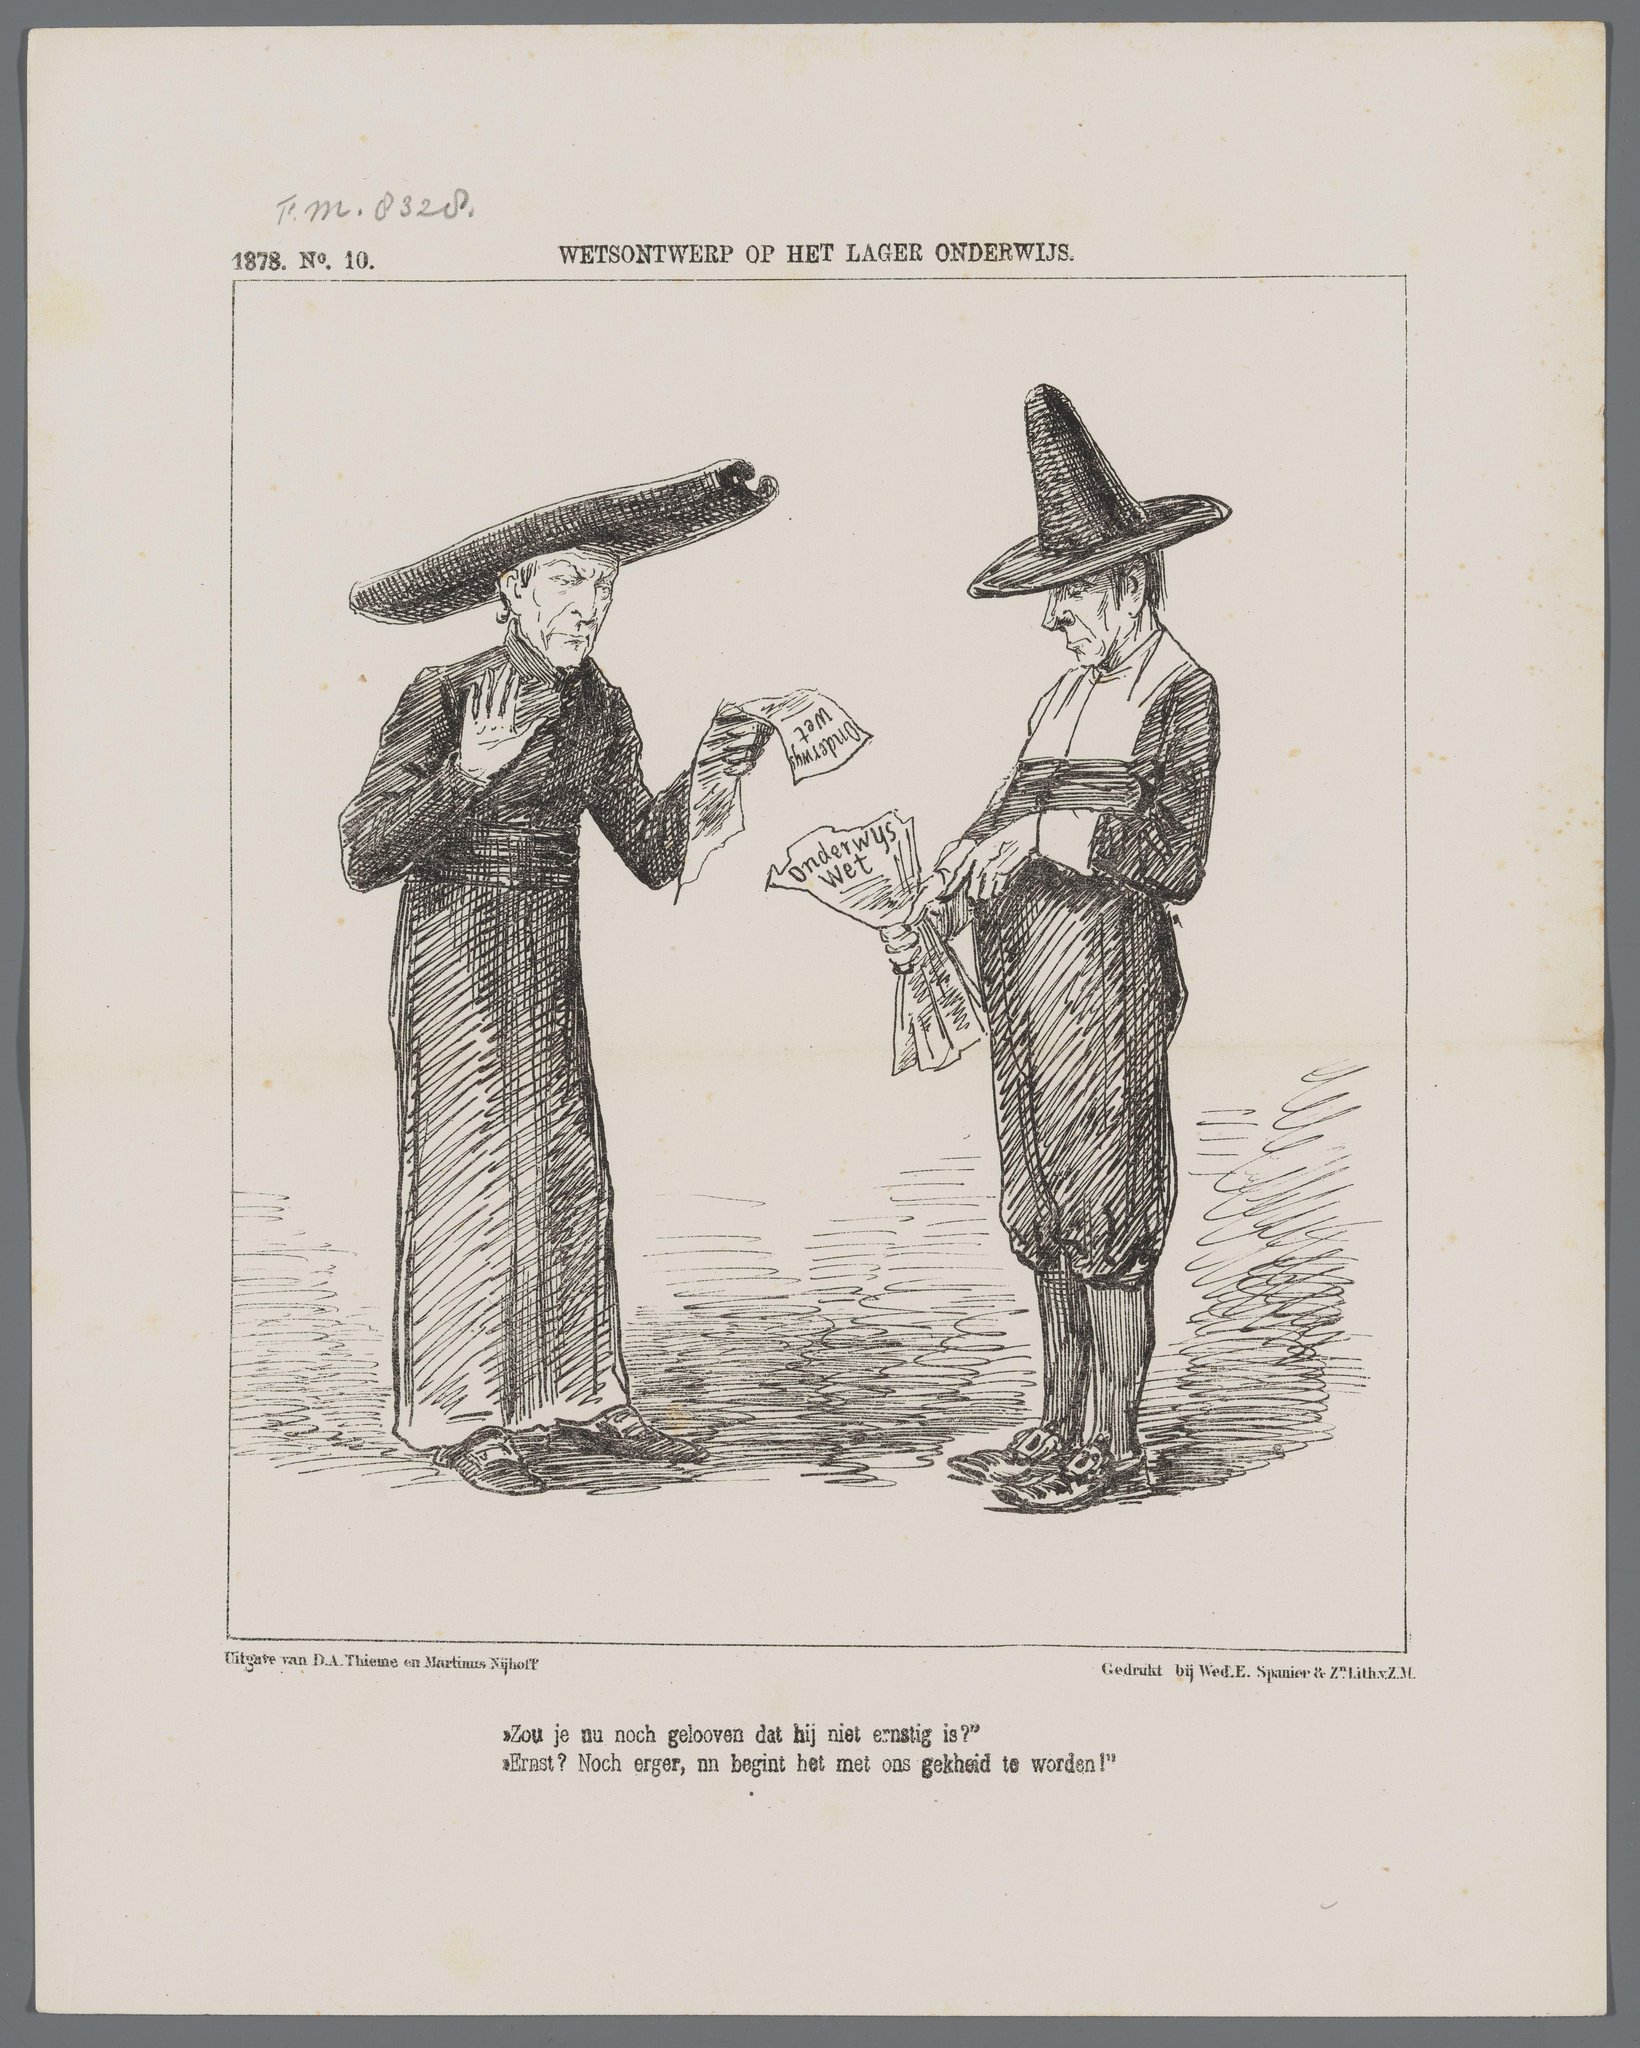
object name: cartoon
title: Wetsontwerp op het lager onderwijs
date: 1878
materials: paper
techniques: lithograph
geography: netherlands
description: Spotprent. Plaat verschenen bij het weekblad De Nederlandsche Spectator, nr. 10, 1878.